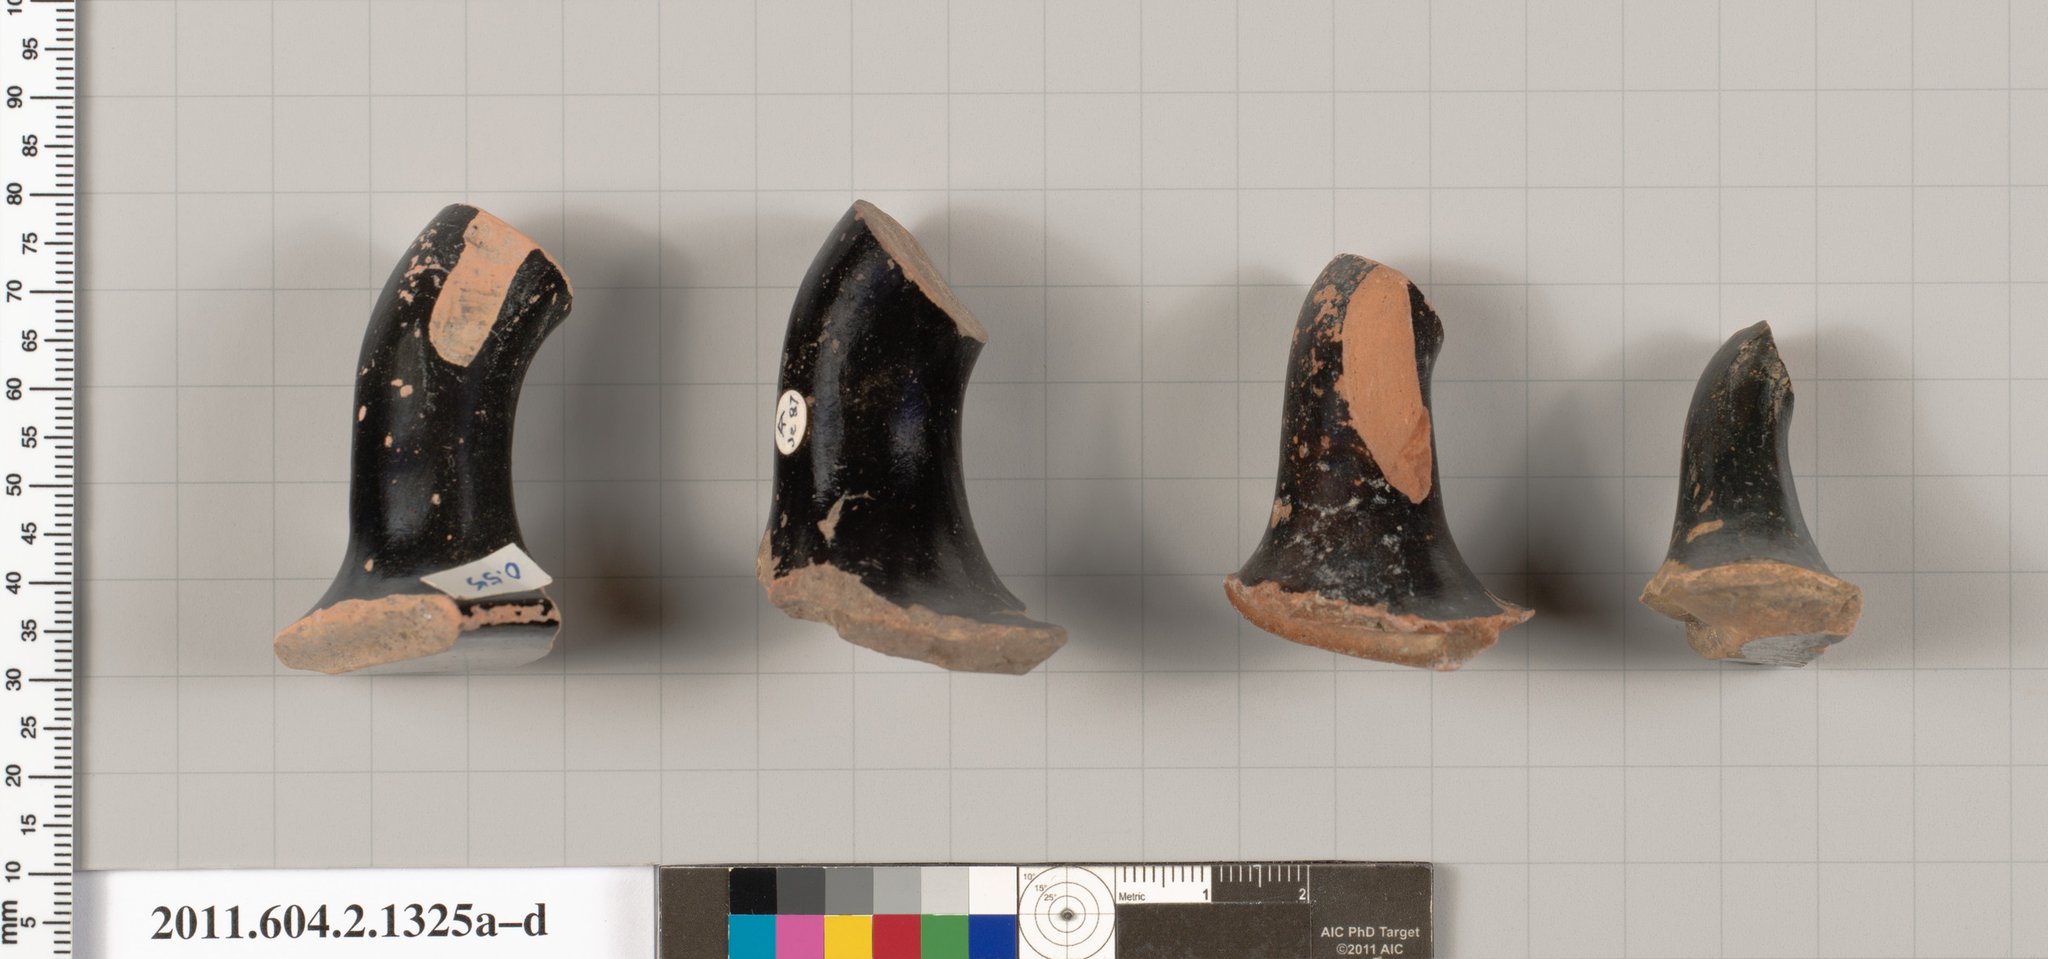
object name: skyphos fragment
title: Terracotta fragments of skyphoi (deep drinking cups)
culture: greek, attic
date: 600-401 BCE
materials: terracotta